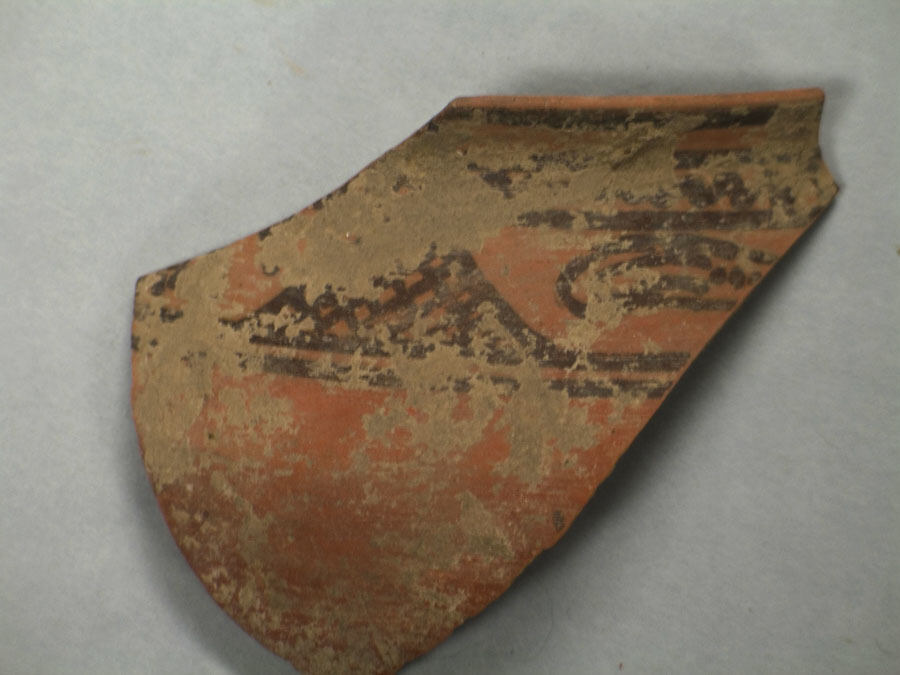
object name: shard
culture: pakistani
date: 301-500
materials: terracotta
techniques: painting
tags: gandhara